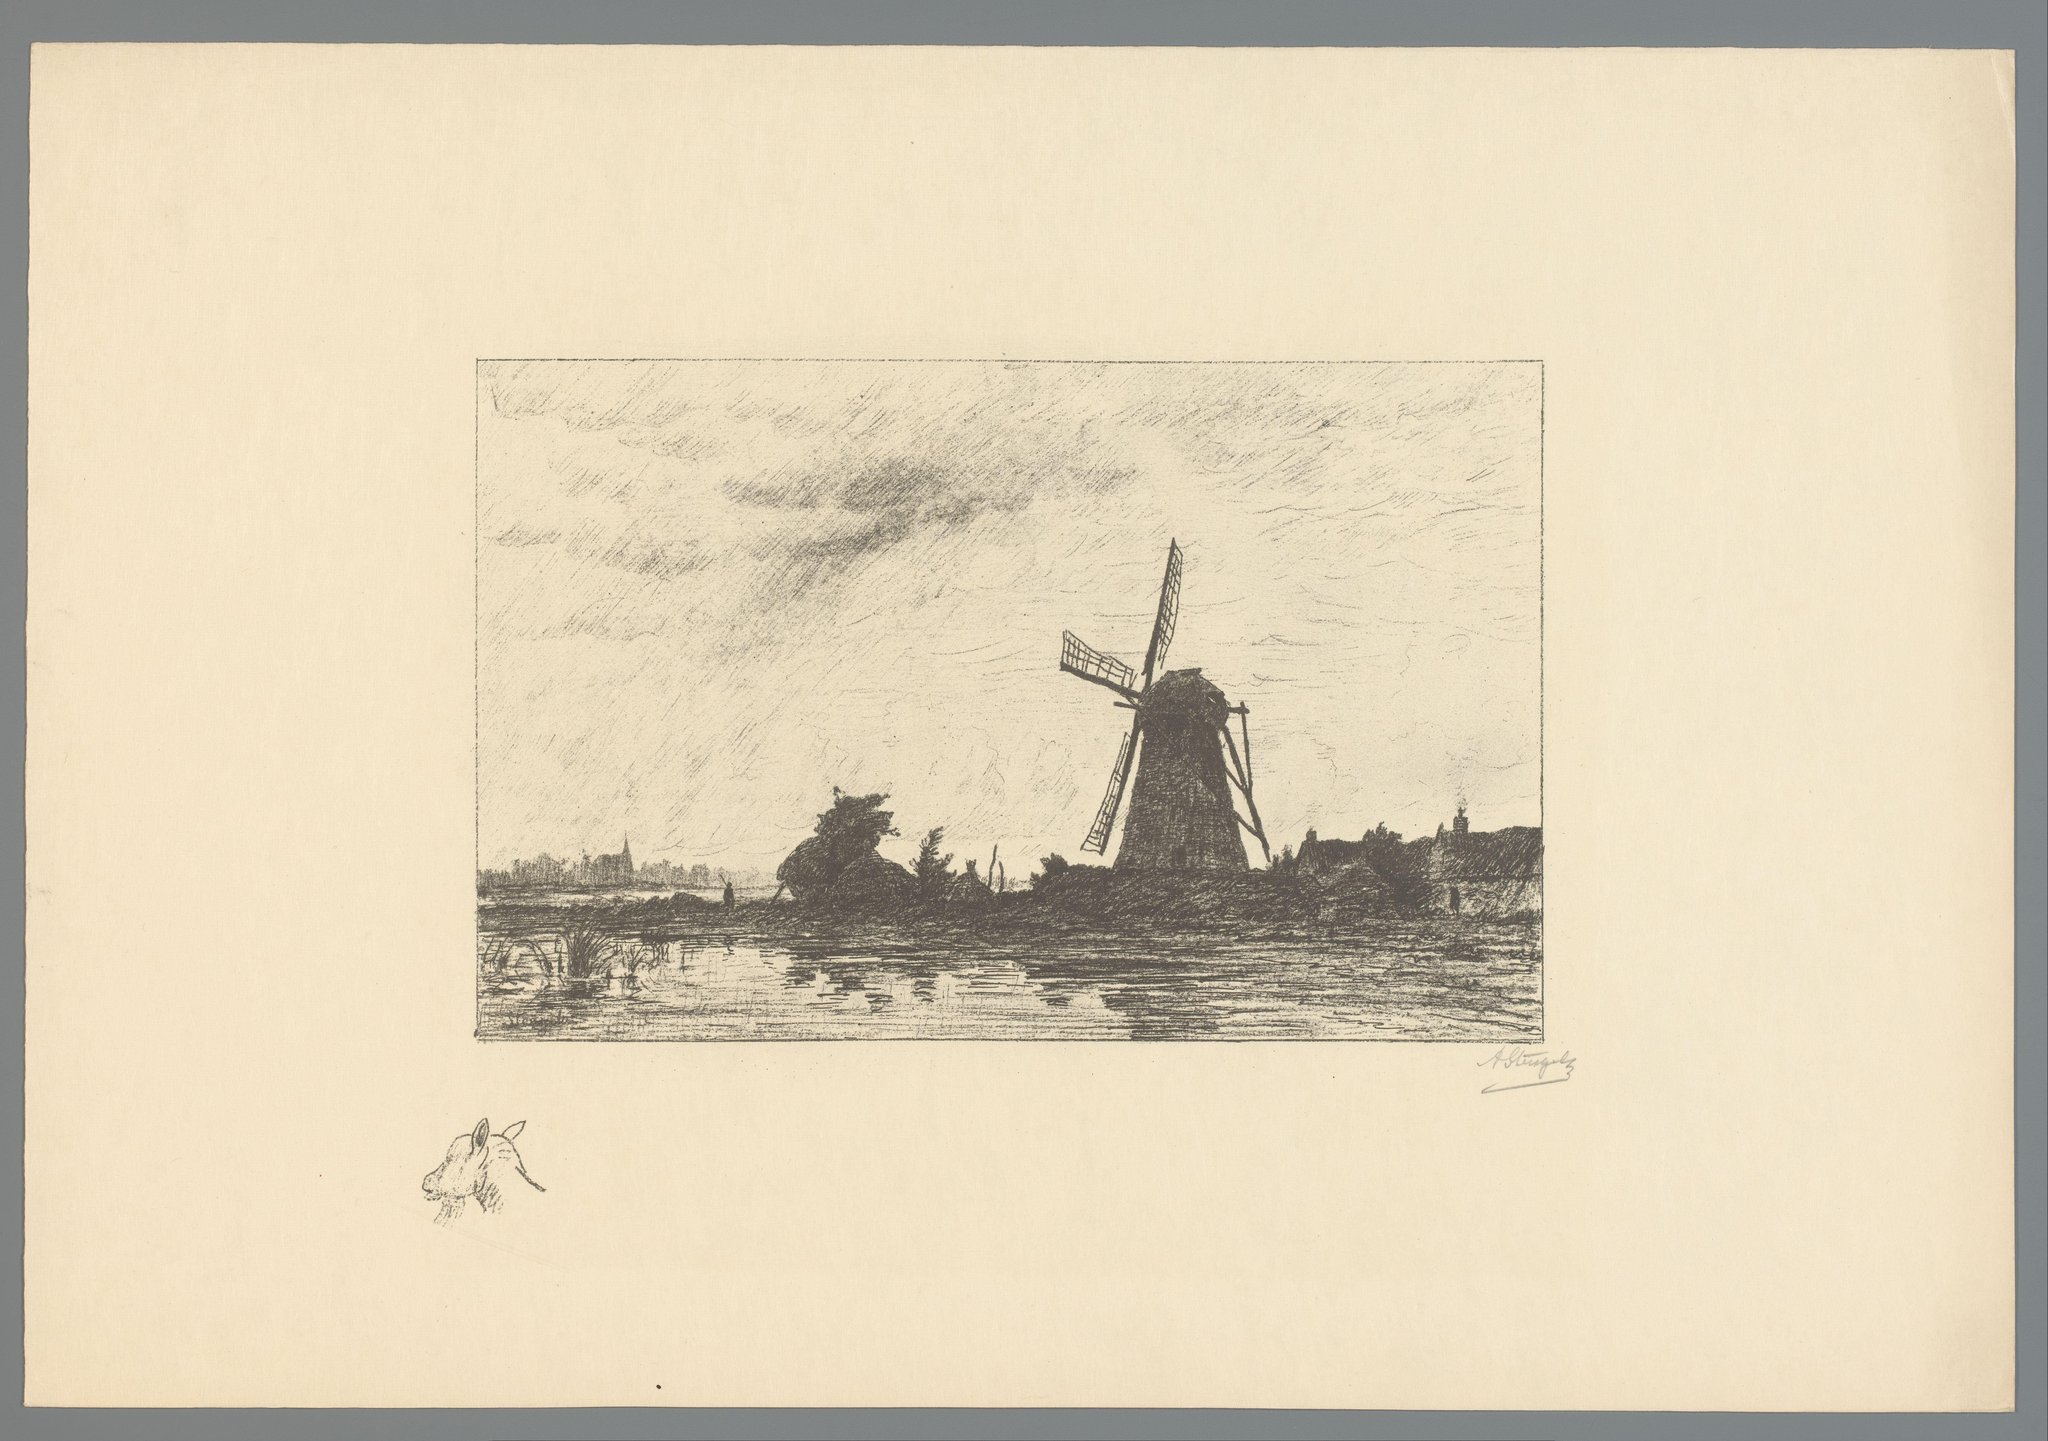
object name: print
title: Molen en lage woningen aan een plas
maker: alphonse stengelin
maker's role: painter, print maker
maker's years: 1852-1938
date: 1876-1910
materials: paper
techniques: lithograph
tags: lake, windmill in landscape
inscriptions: collector's mark: Lugt 2228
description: Linksonder een remarque met een geitenkop.